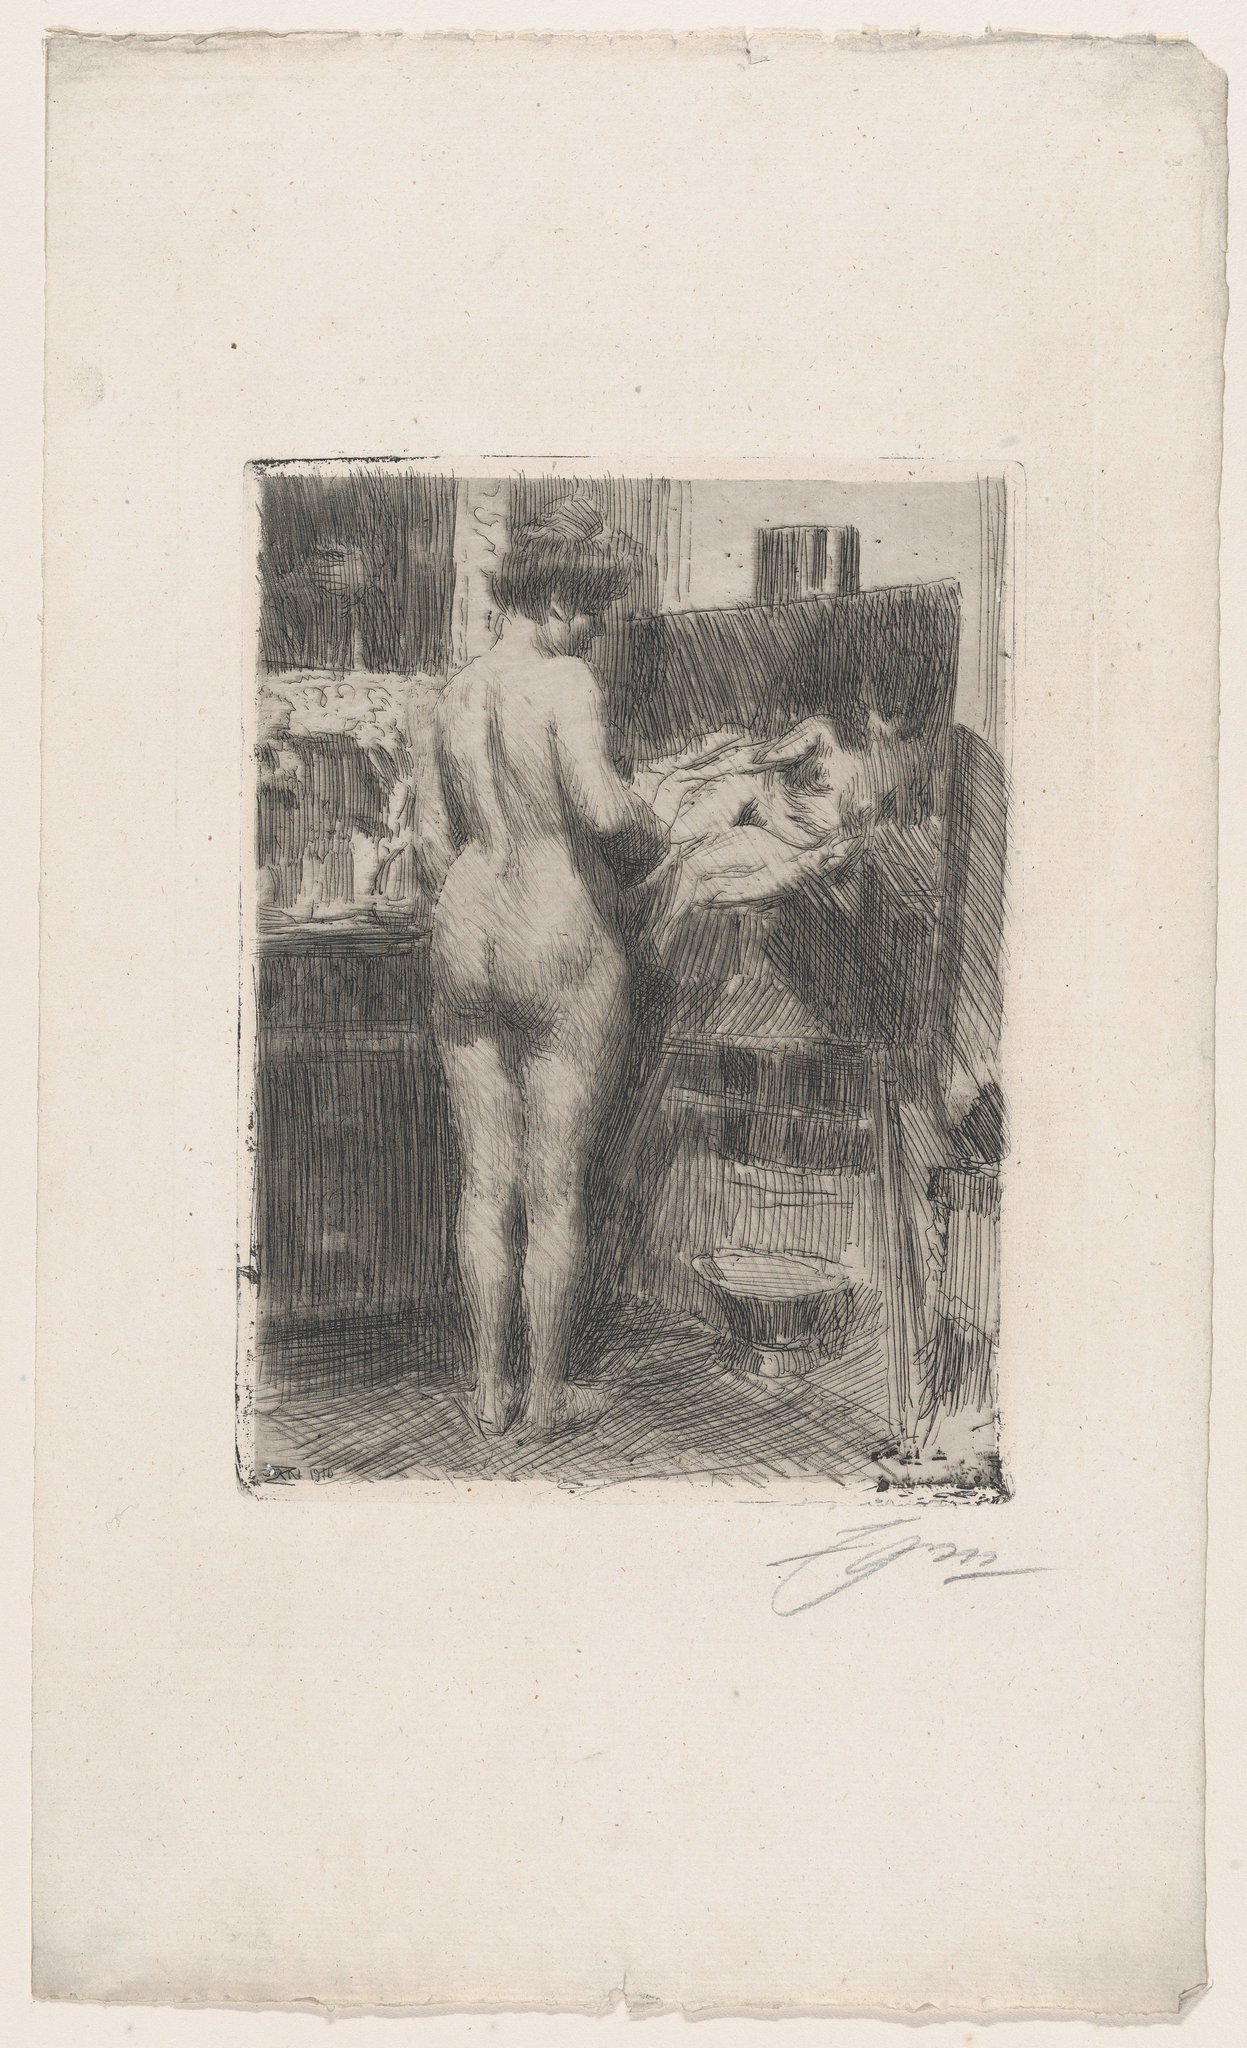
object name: print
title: Model Before Picture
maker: anders zorn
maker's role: artist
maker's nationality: swedish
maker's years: 1860-1920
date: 1910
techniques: etching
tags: female nudes